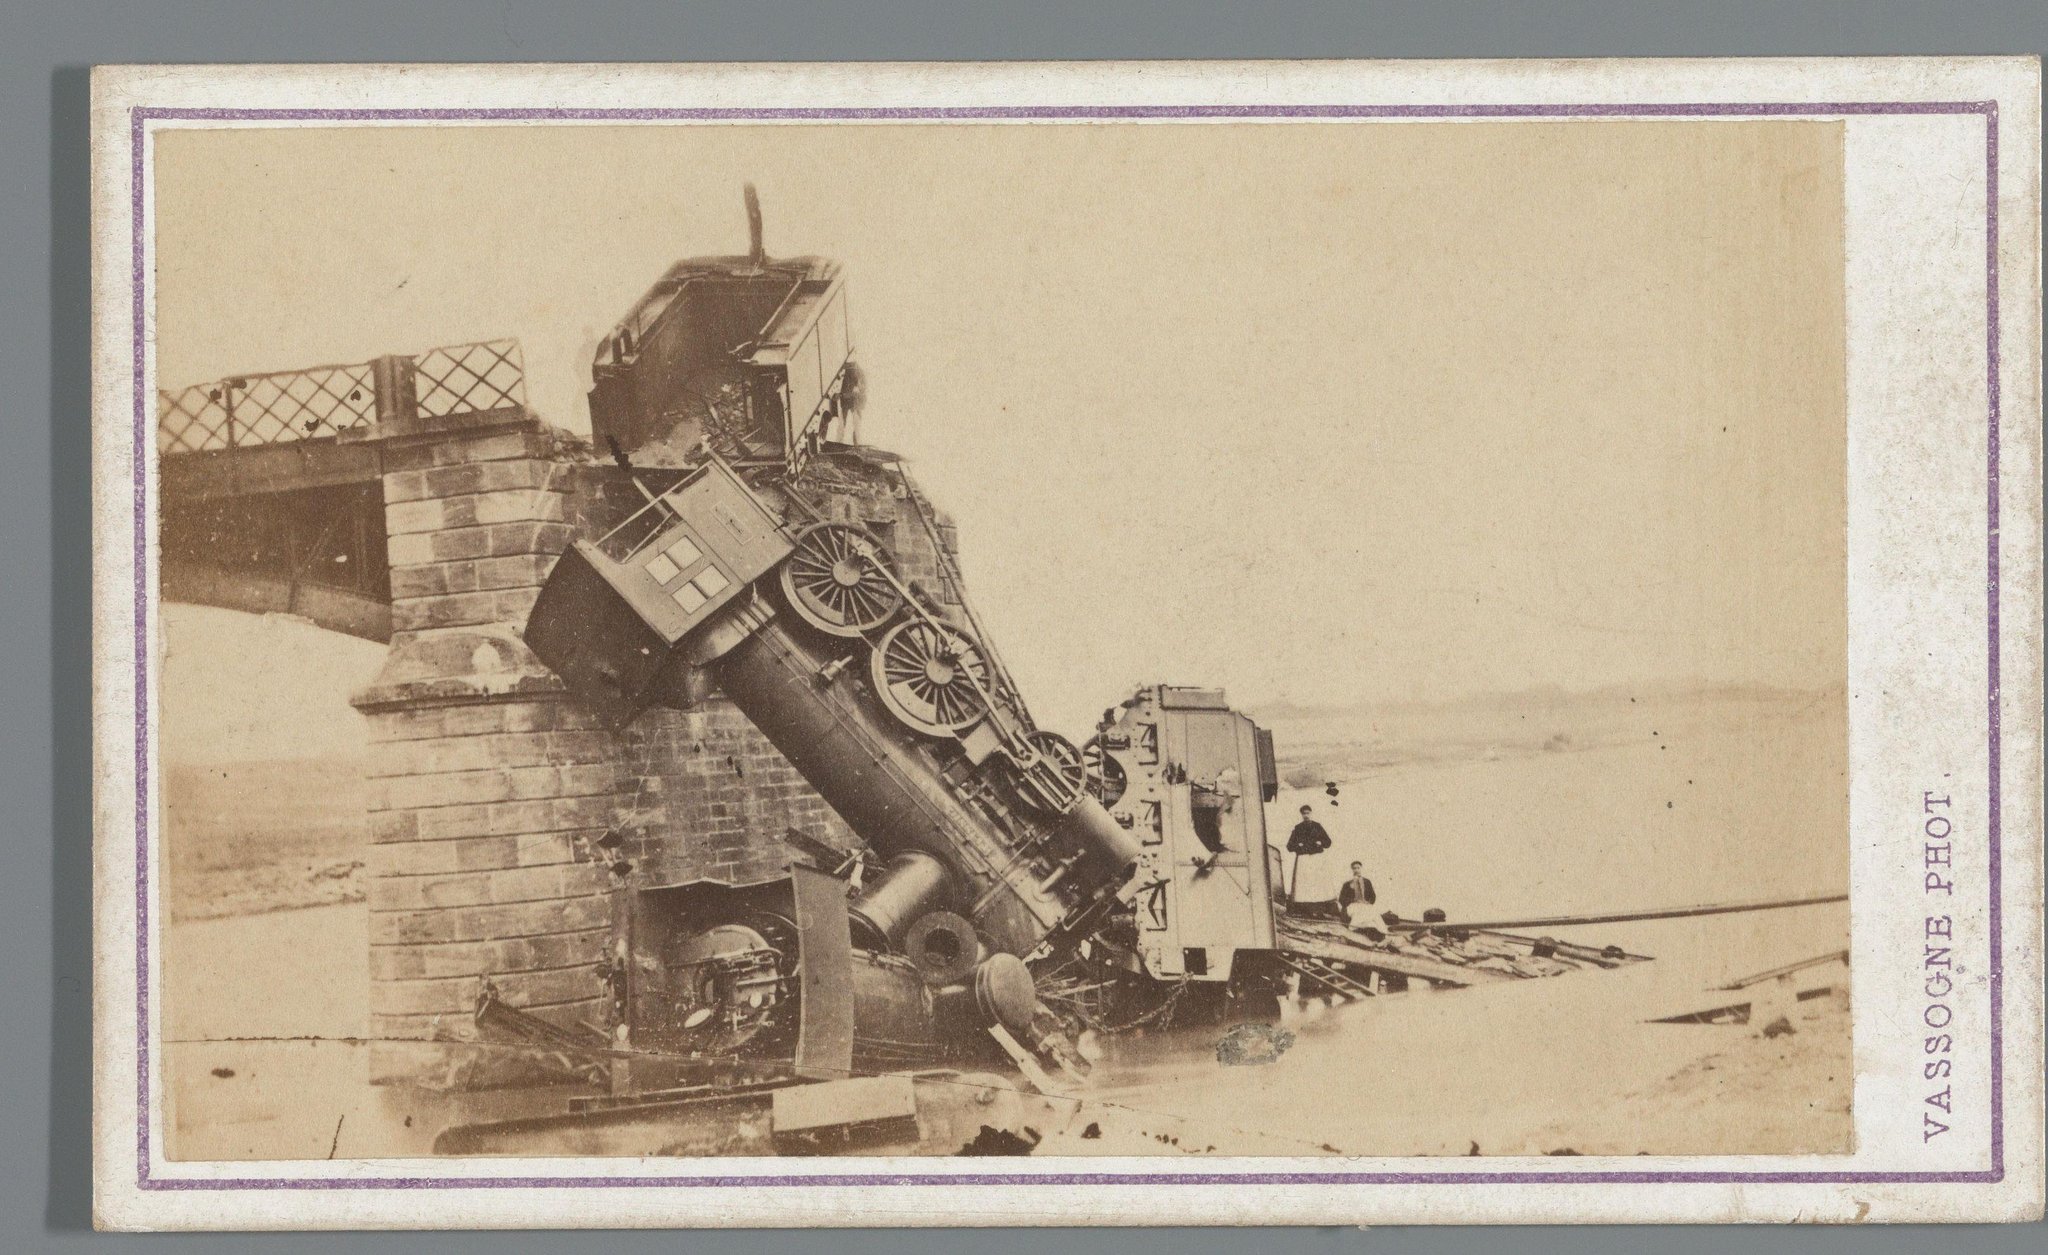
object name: photograph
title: Duitse locomotief op de brug bij Le Theux, kapotgeschoten tijdens de Frans-Duitse oorlog van 1870-71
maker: louis eugène vassogne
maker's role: fotograaf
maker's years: 1836-1881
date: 1870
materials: cardboard, paper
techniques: albumen print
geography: le theux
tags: accident with locomotive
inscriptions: address: ‘95, Sous les Allées, 95,/ CHARLESVILLE’